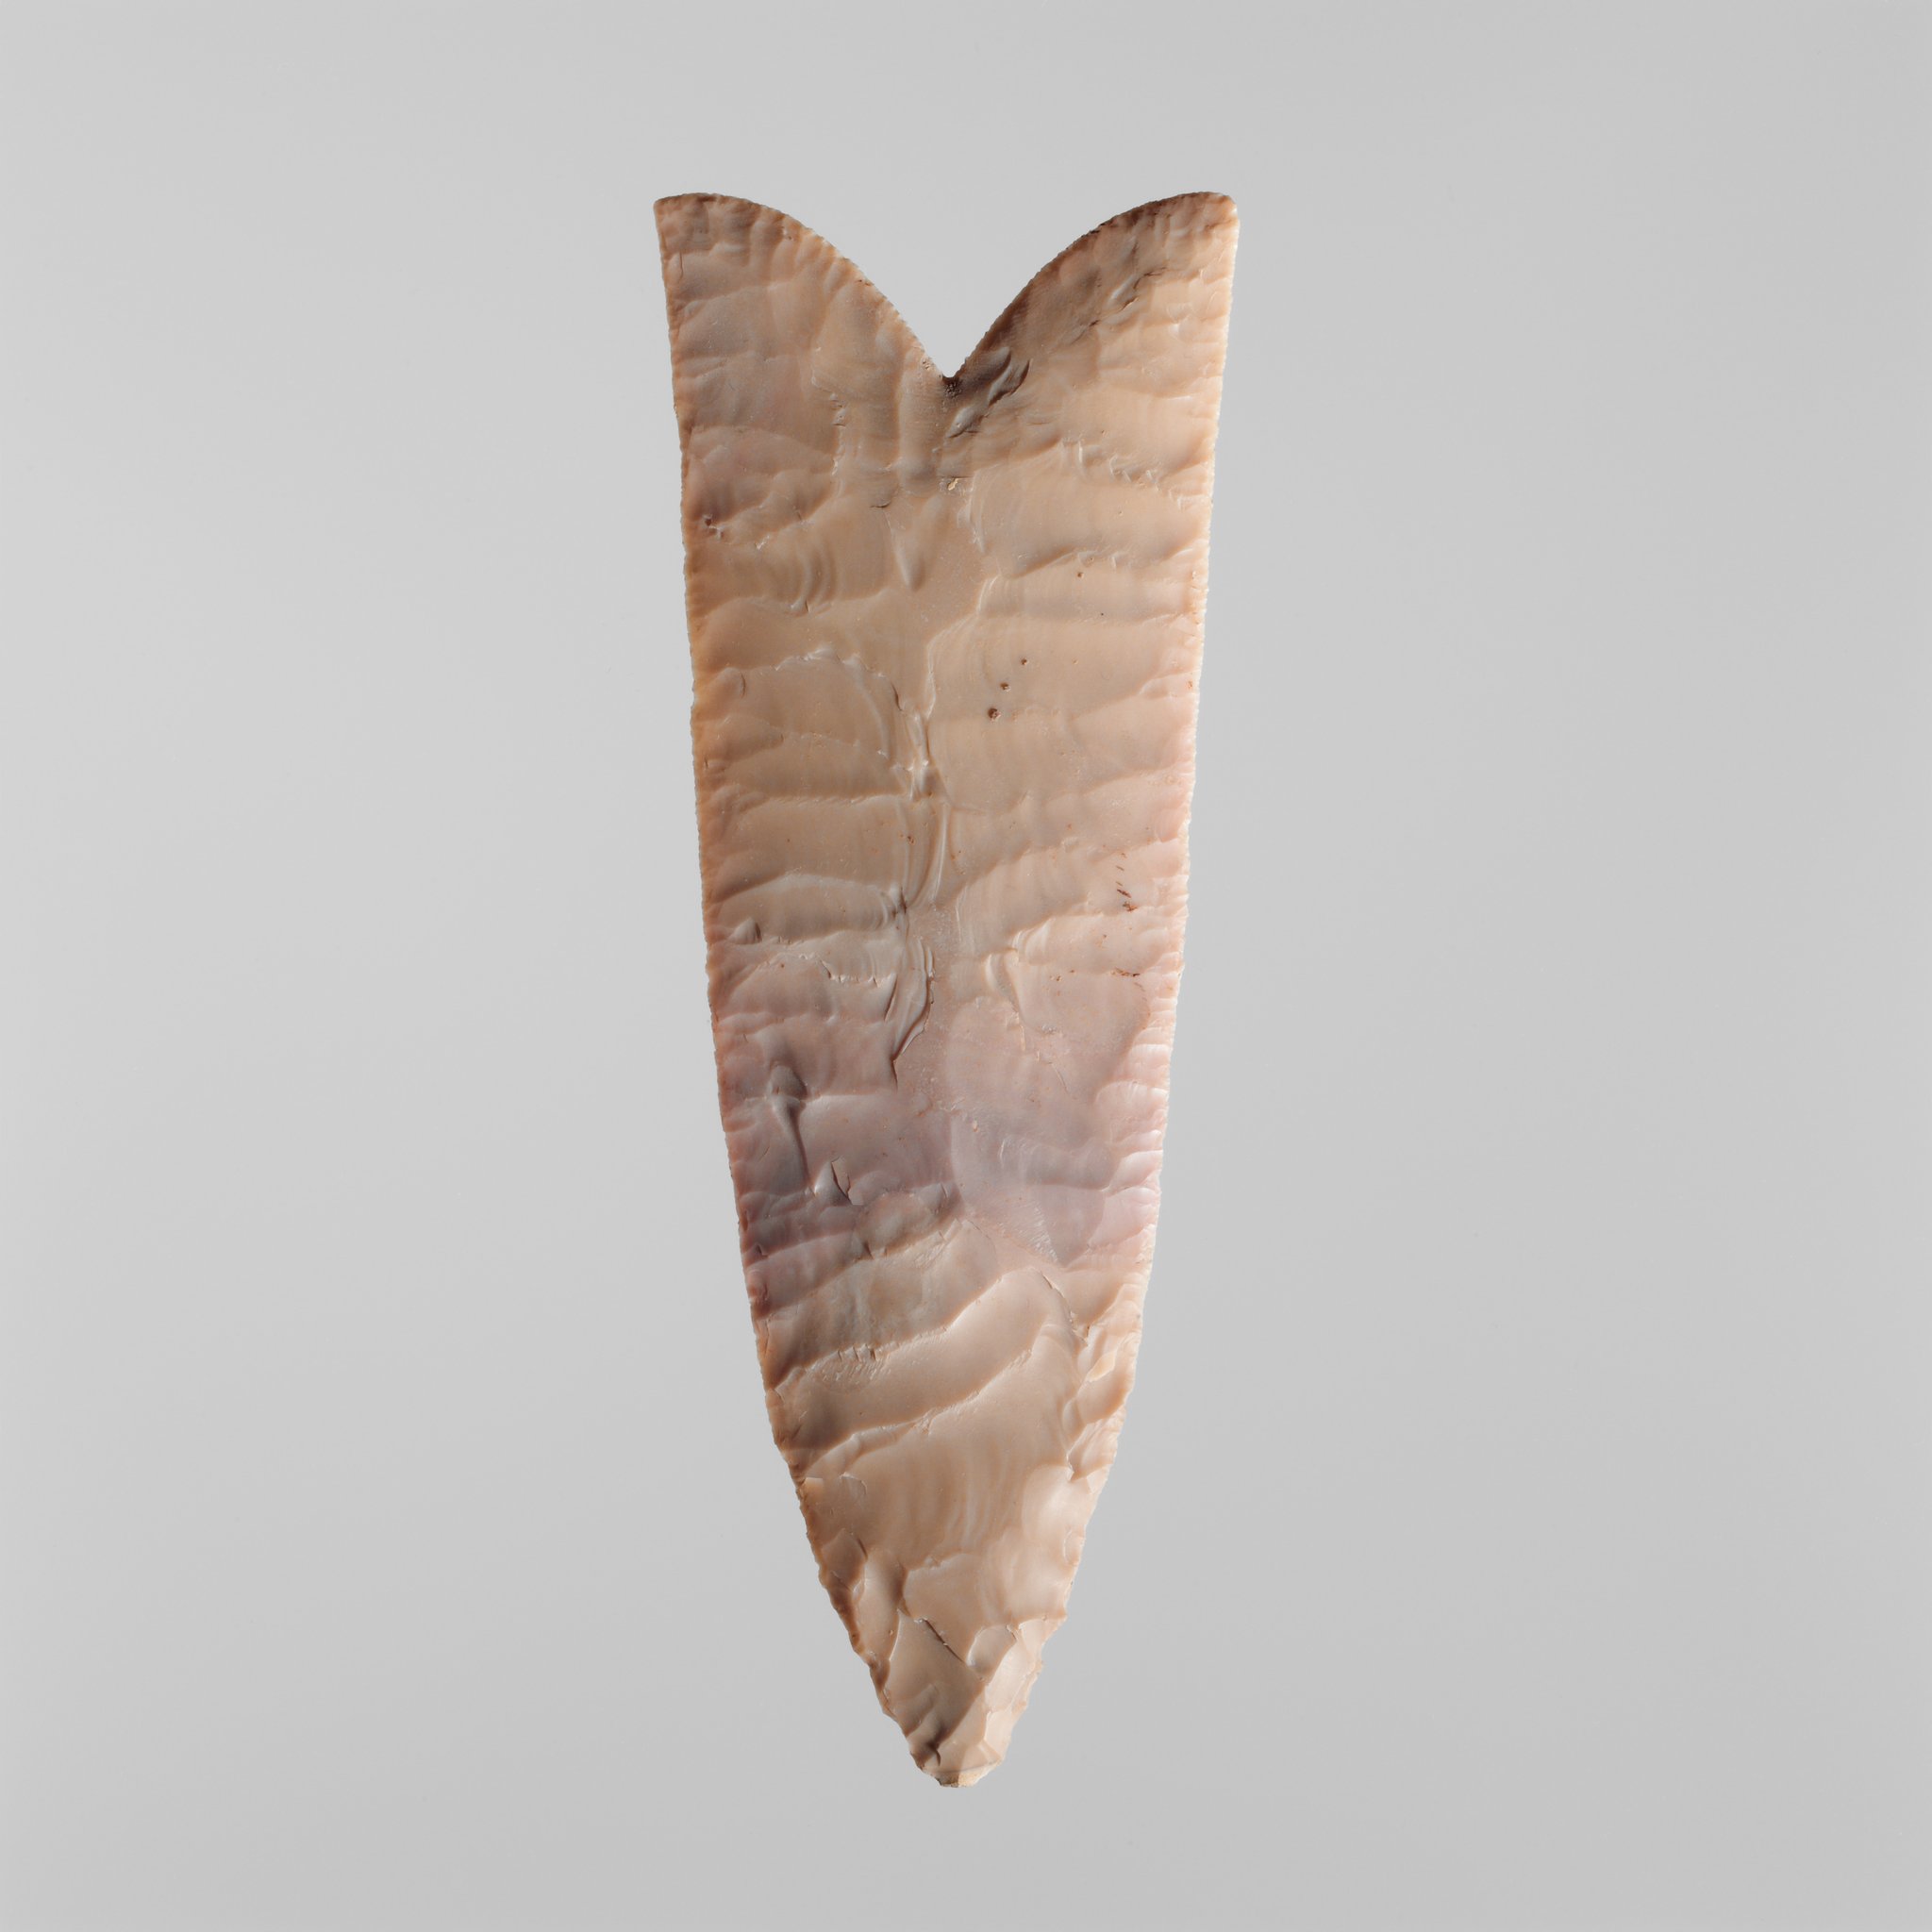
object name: knife, fishtail, bifacial knife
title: Fishtail Knife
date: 3650-3300 BCE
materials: stone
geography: egypt